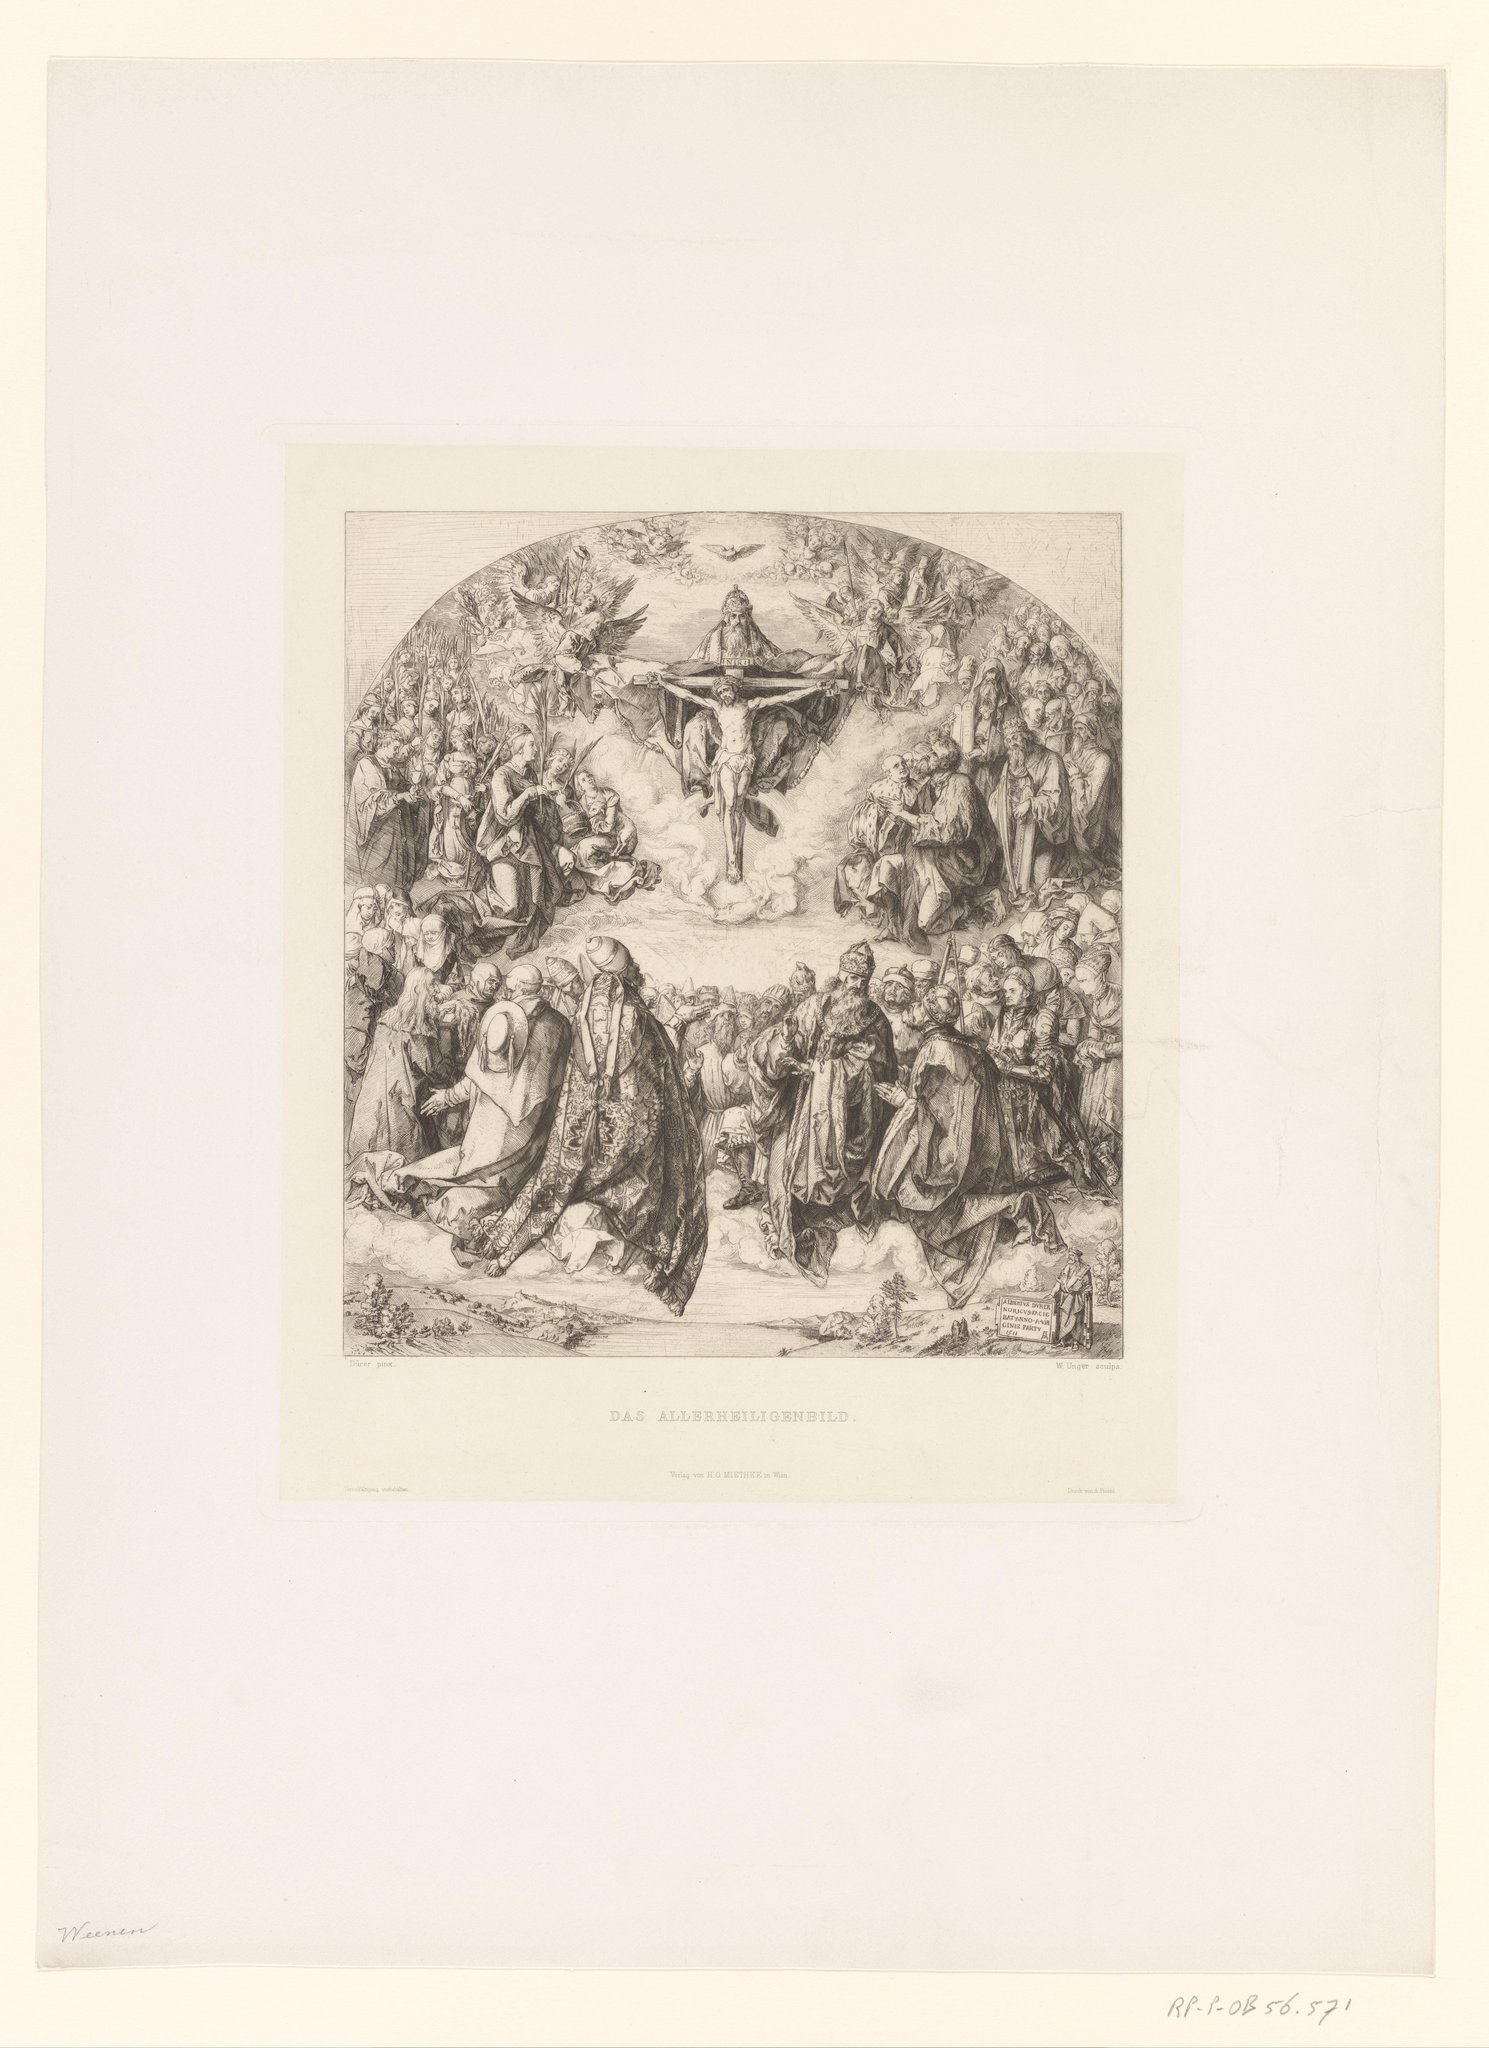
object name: print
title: Das Allerheiligenbild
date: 1861-1889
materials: paper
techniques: etching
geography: vienna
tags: god the father holding the crucifix, 'gnadenstuhl', mercy-seat, throne of grace, devotion: all saints picture, 'allerheiligenbild'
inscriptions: collector's mark: Lugt 2228